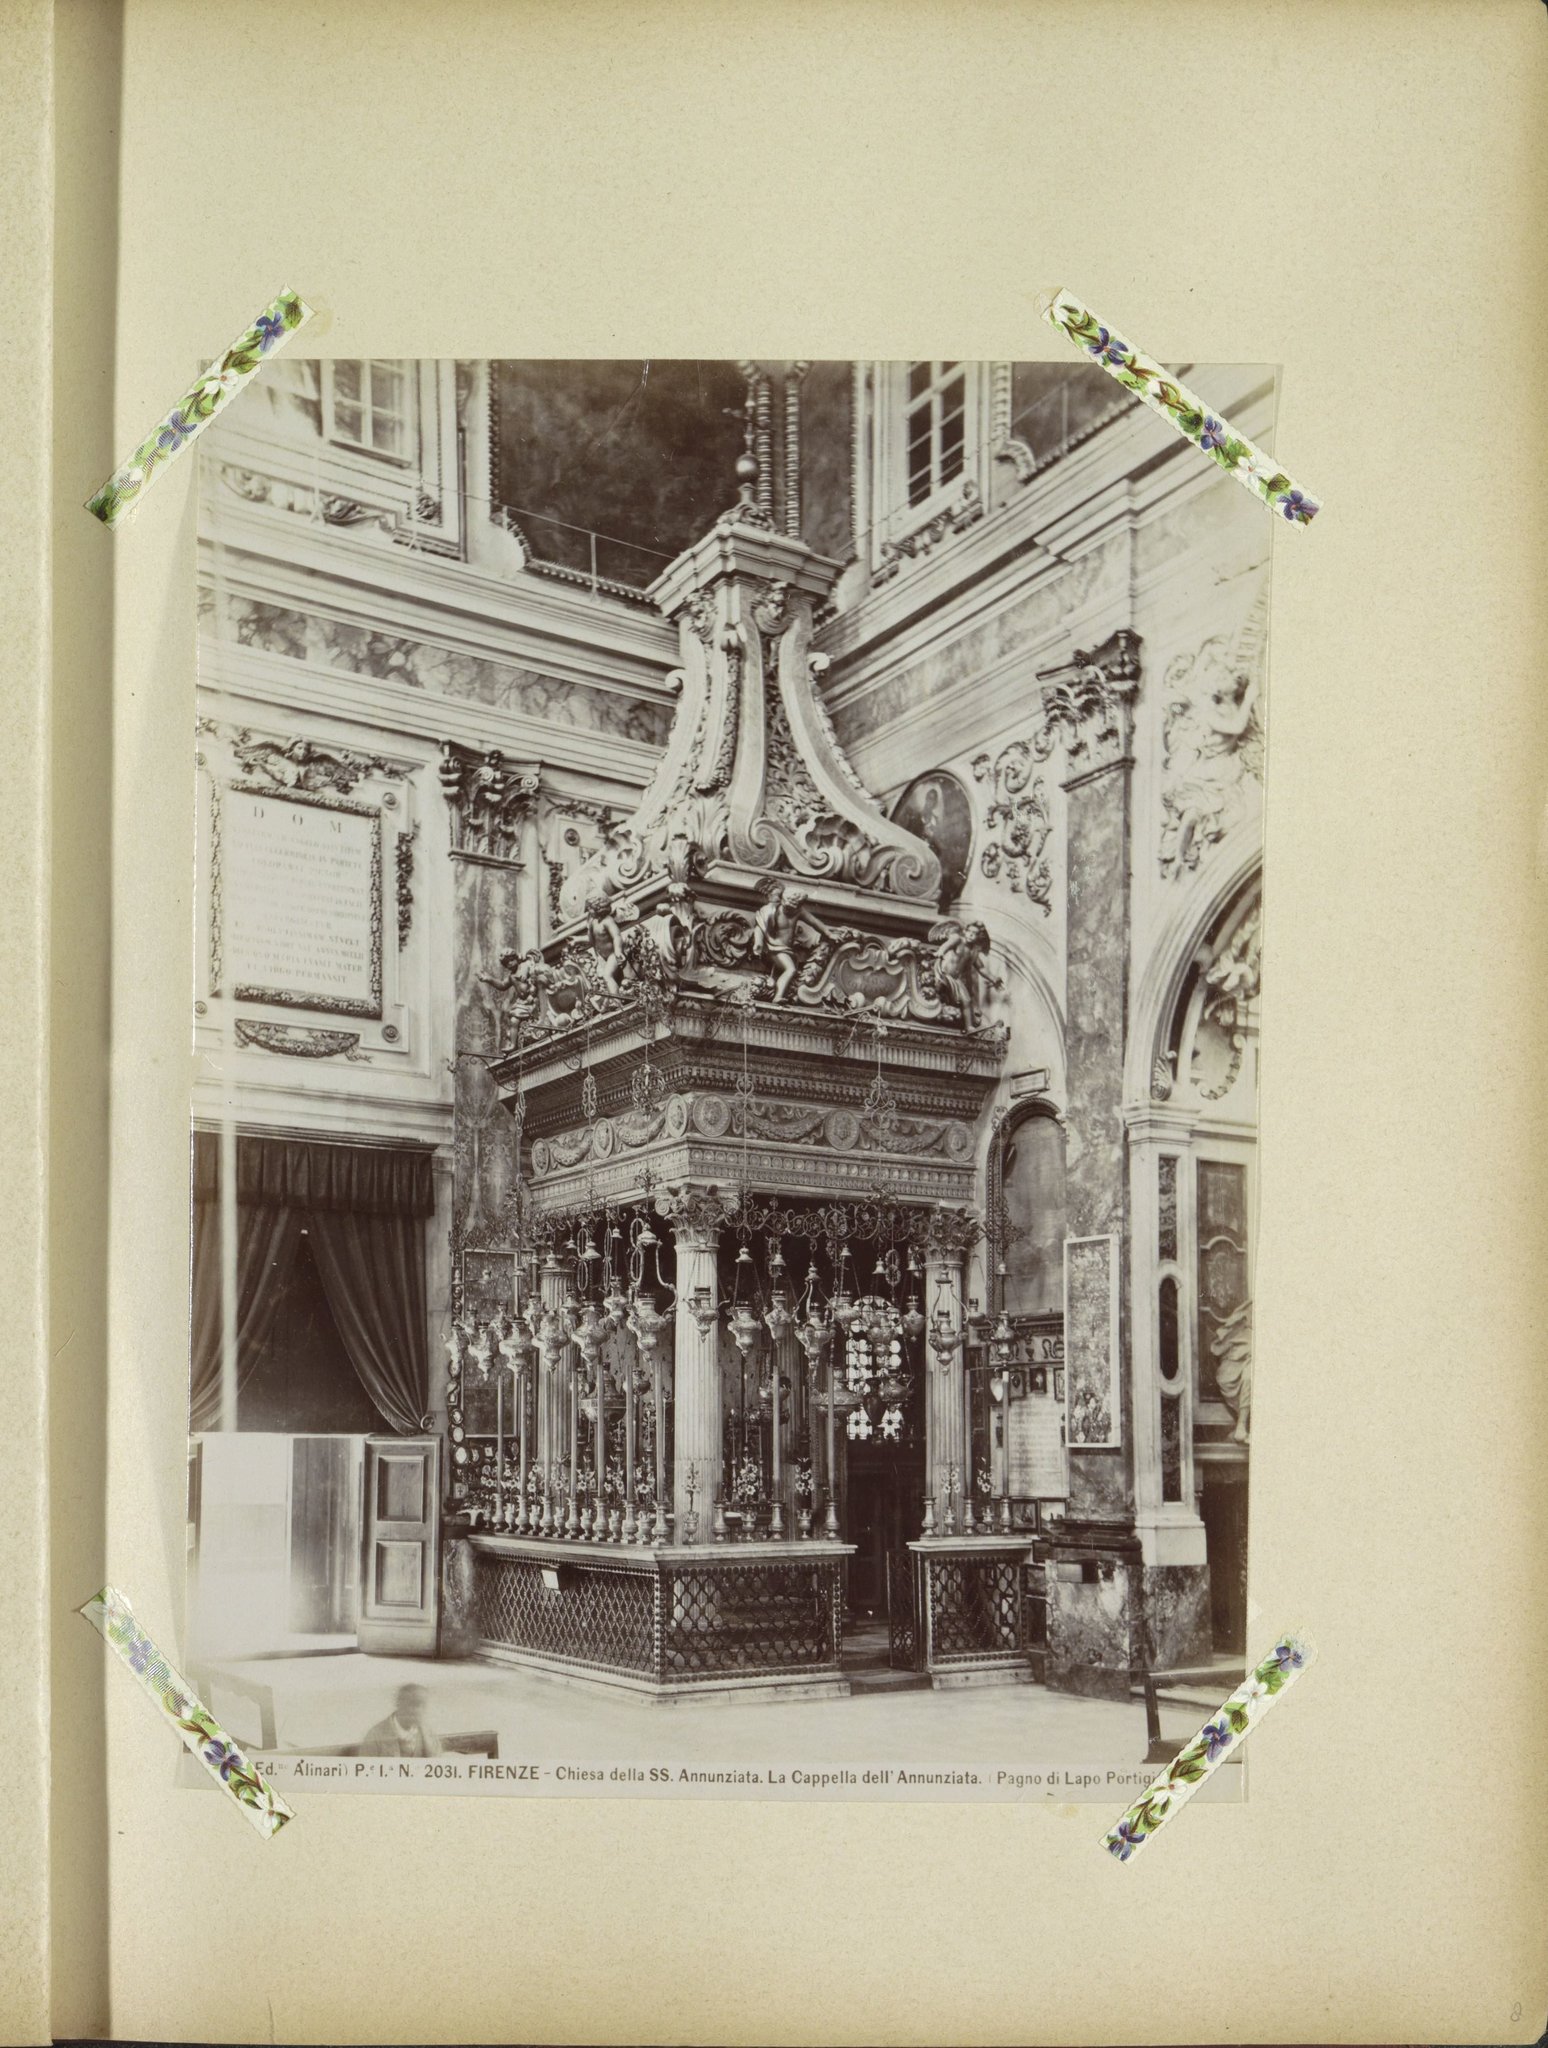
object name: photograph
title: Firenze - Chiesa della SS. Annunziata. La Cappella dell'Annunziata (Pagno di Lapo Porigiani.)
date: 1860-1900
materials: photographic support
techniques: albumen print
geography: basilica della santissima annunziata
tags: parts of church interior: chapel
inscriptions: number: ‘P.e.1.a No. 2031’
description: Onderdeel van Fotoalbum met opnames van bezienswaardigheden in Italiaanse steden en van kunstwerken.